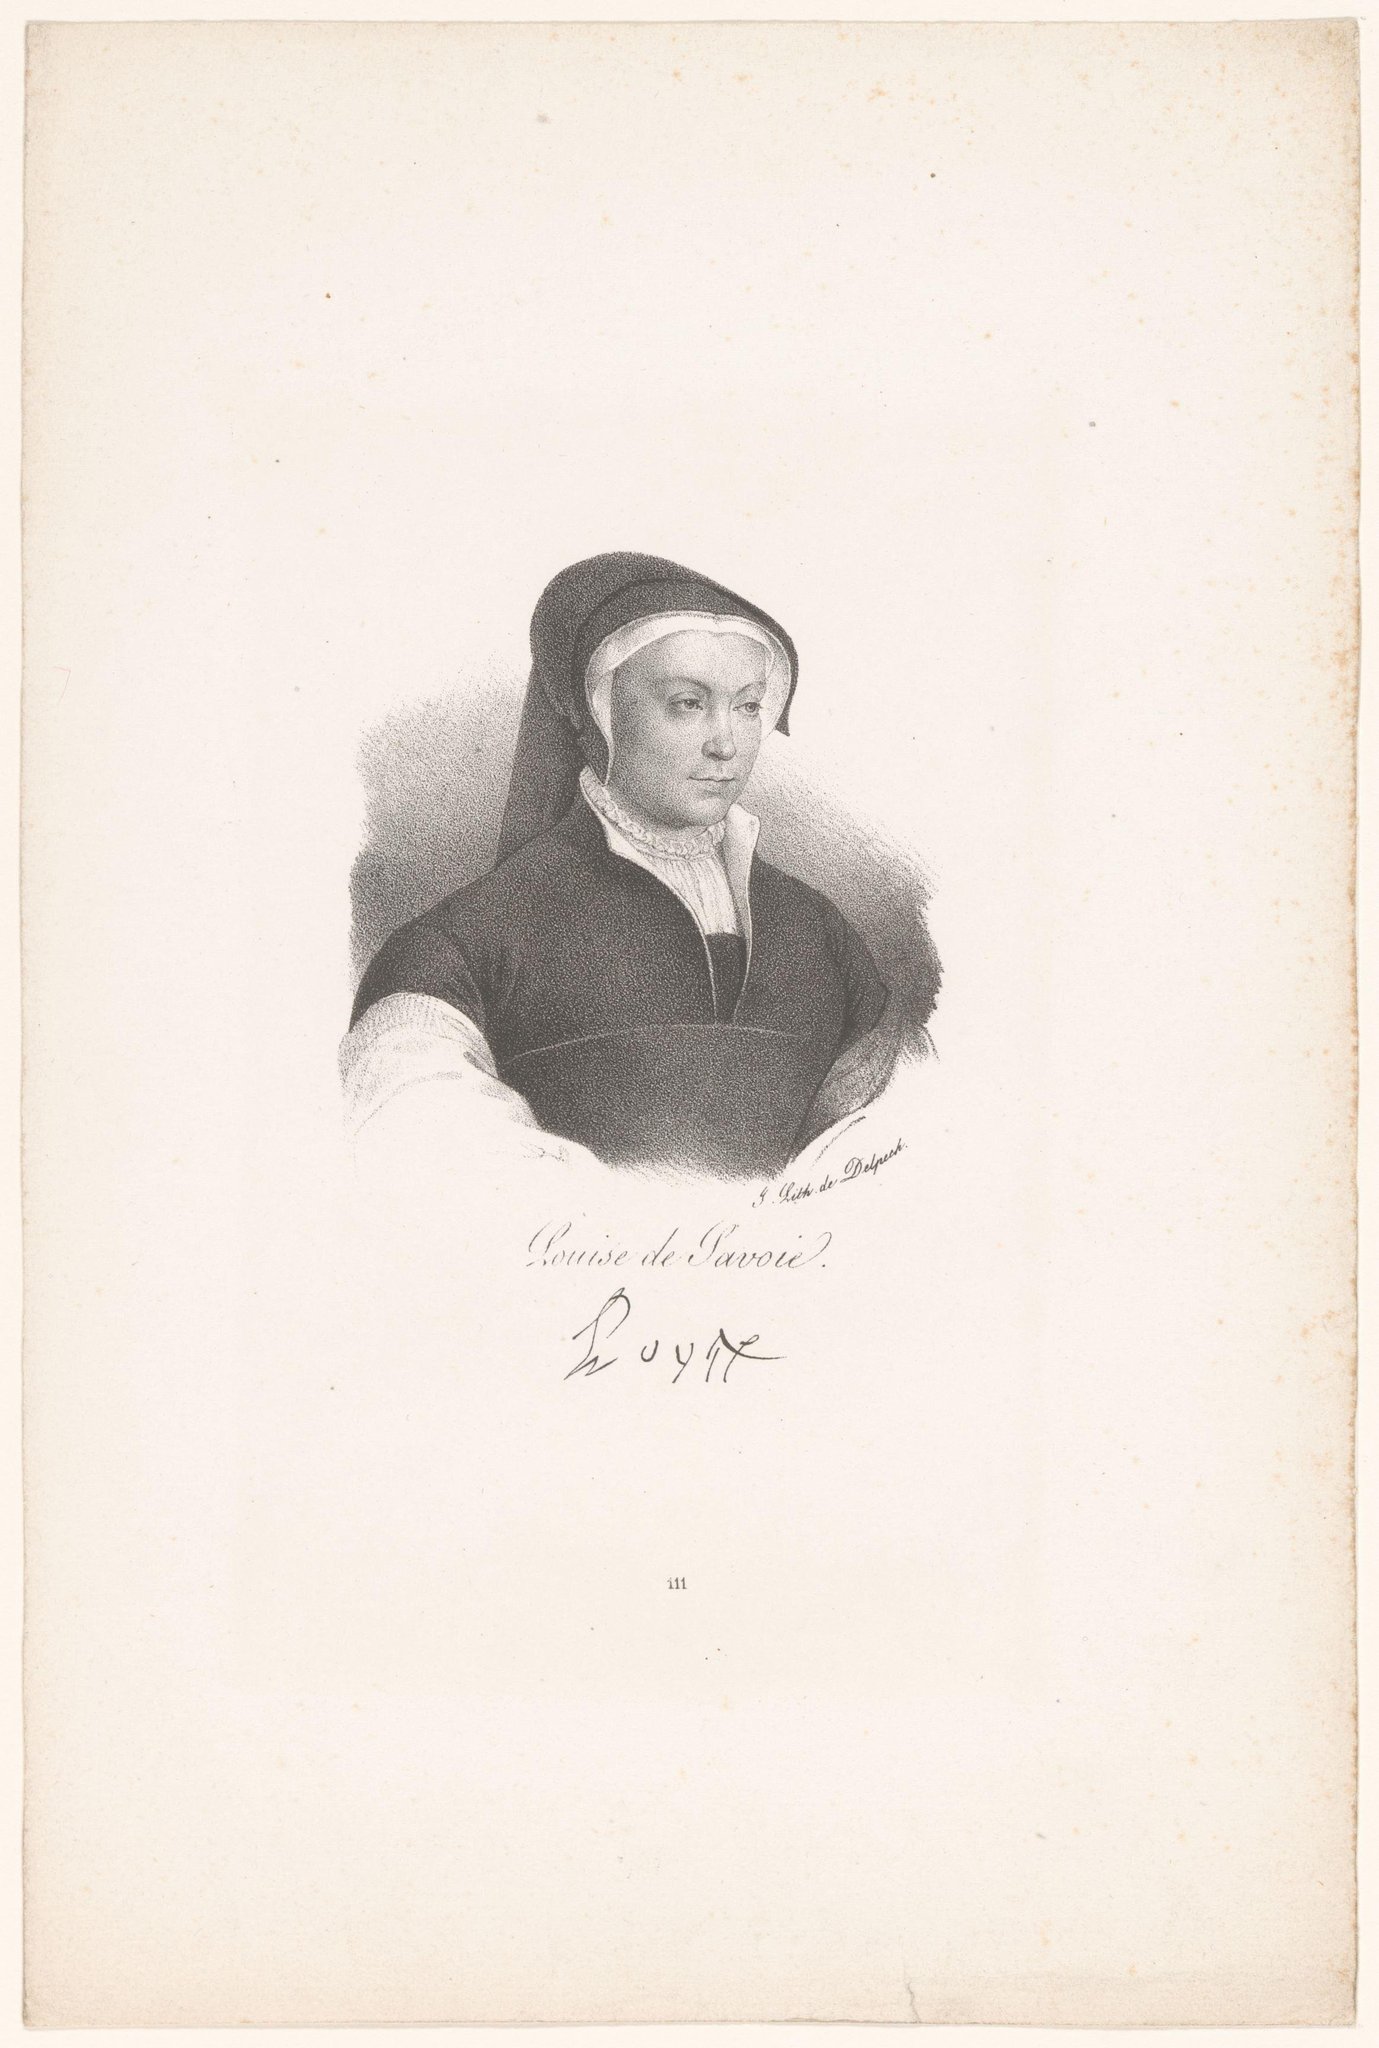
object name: print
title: Portret van Louise van Savoye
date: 1818-1842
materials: paper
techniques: lithograph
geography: paris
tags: historical persons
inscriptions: collector's mark: Lugt 2228a